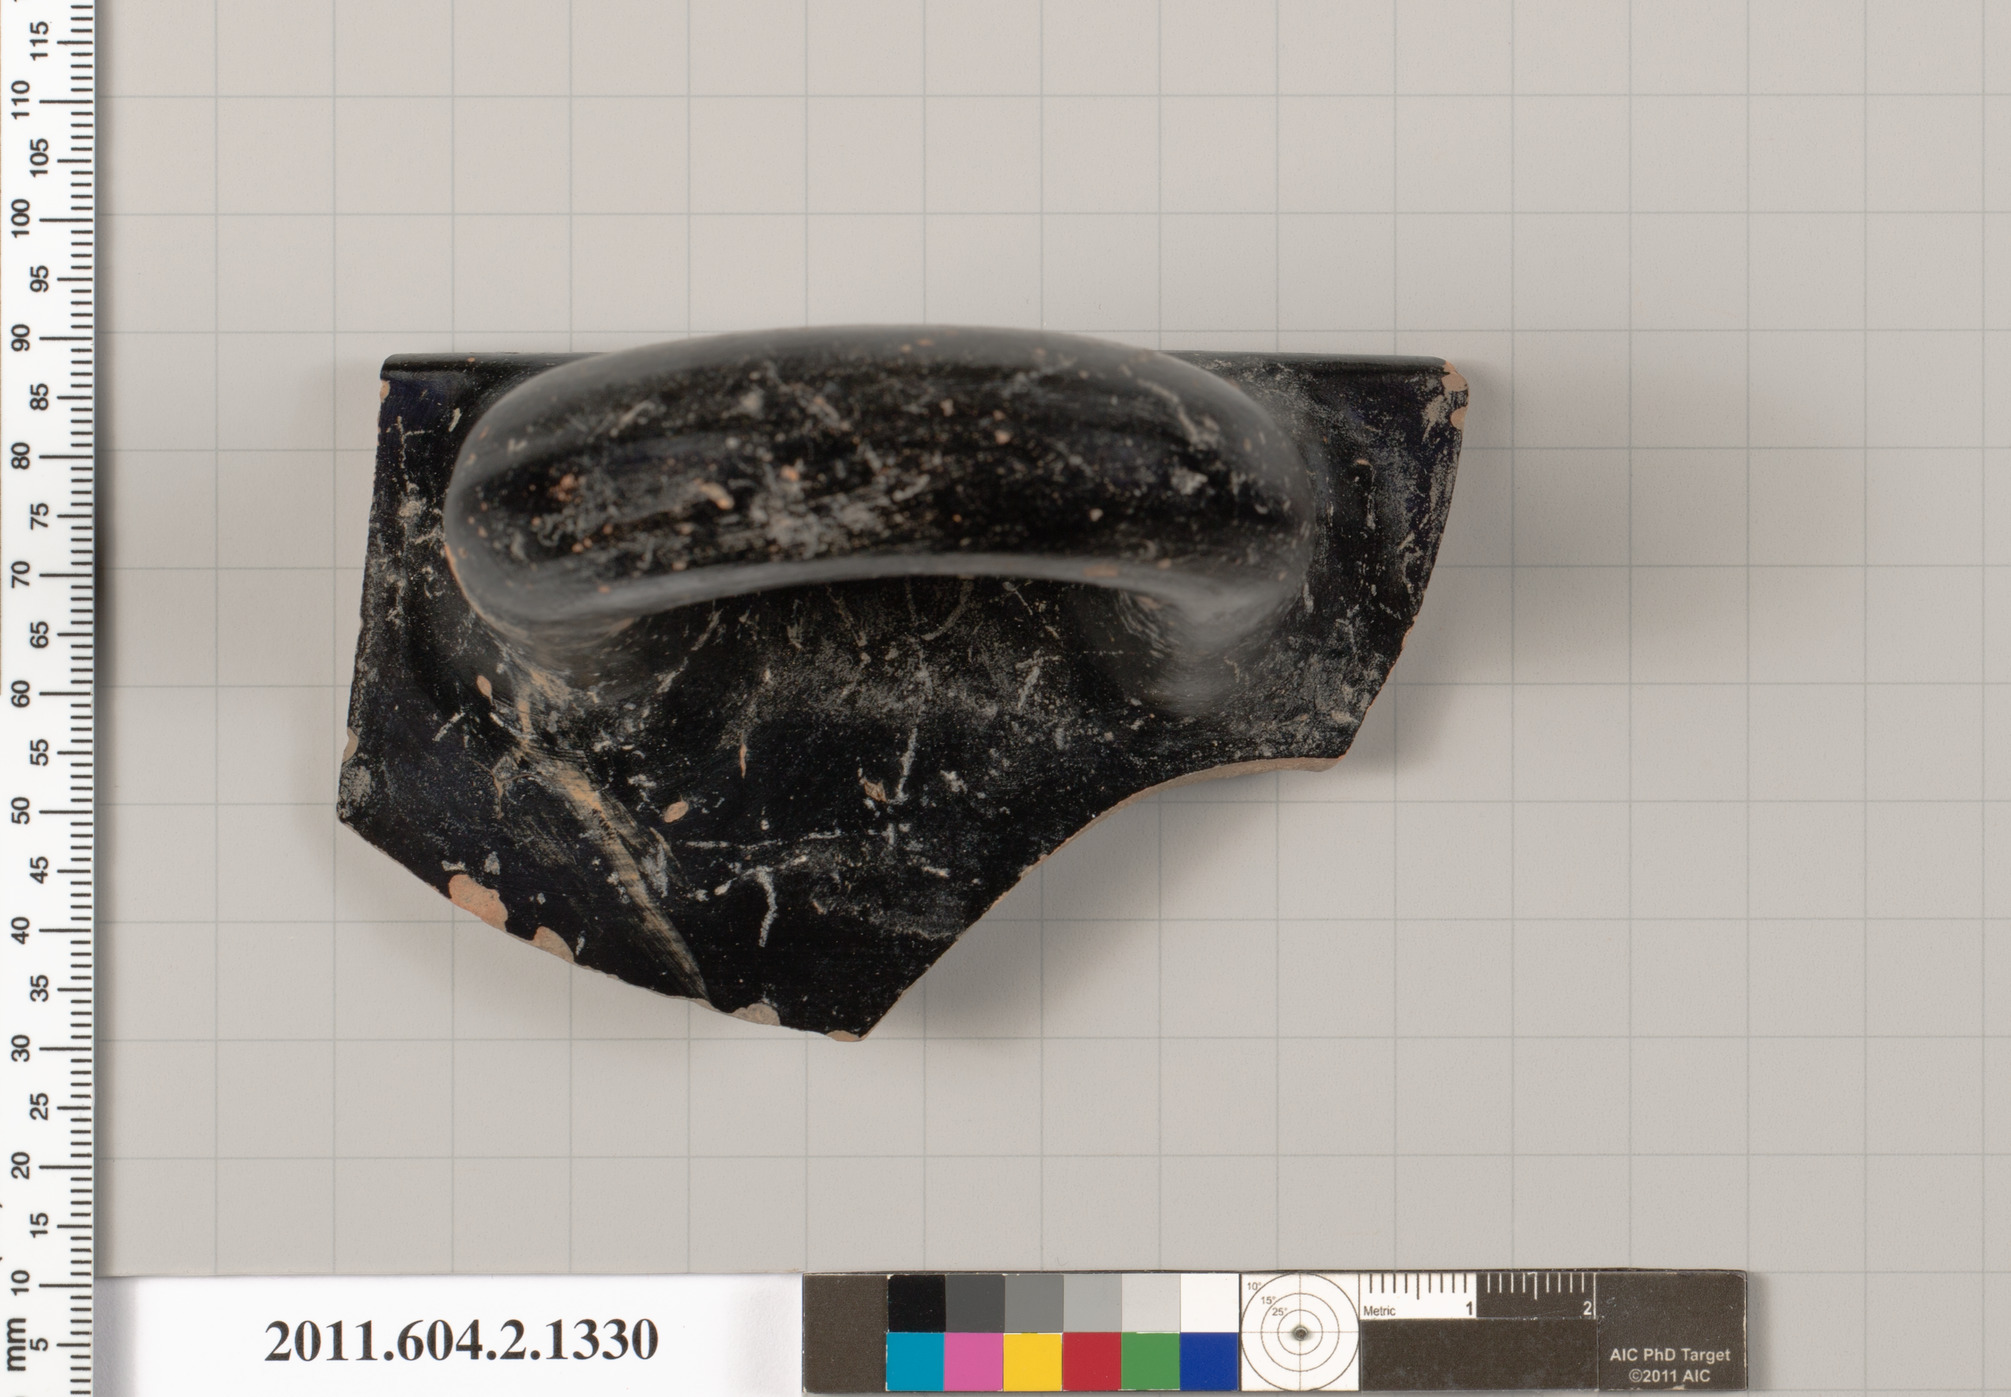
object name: skyphos fragment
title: Terracotta fragment of a skyphos (deep drinking cup)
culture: greek, attic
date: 500-451 BCE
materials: terracotta